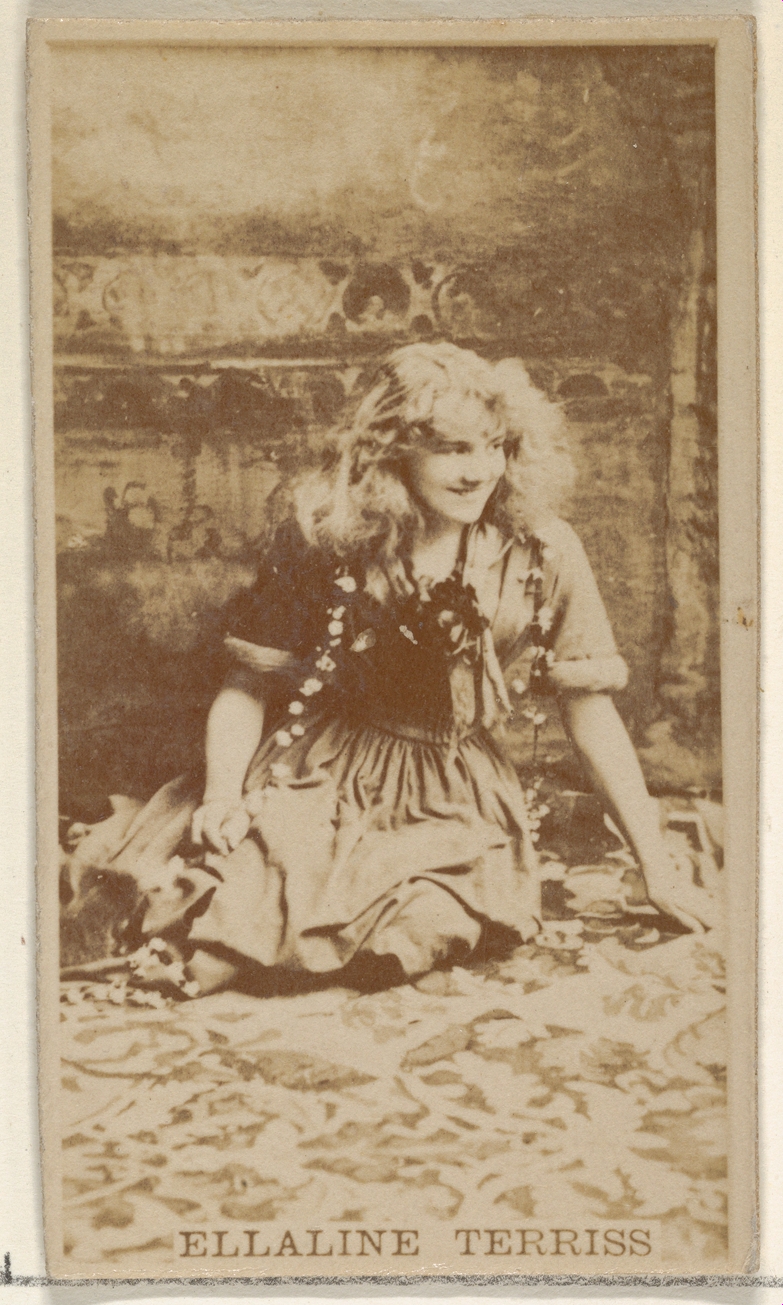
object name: photograph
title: Ellaline Terriss, from the Actors and Actresses series (N45, Type 8) for Virginia Brights Cigarettes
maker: allen & ginter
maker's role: publisher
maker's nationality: american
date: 1888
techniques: albumen silver print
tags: portraits,women,actresses